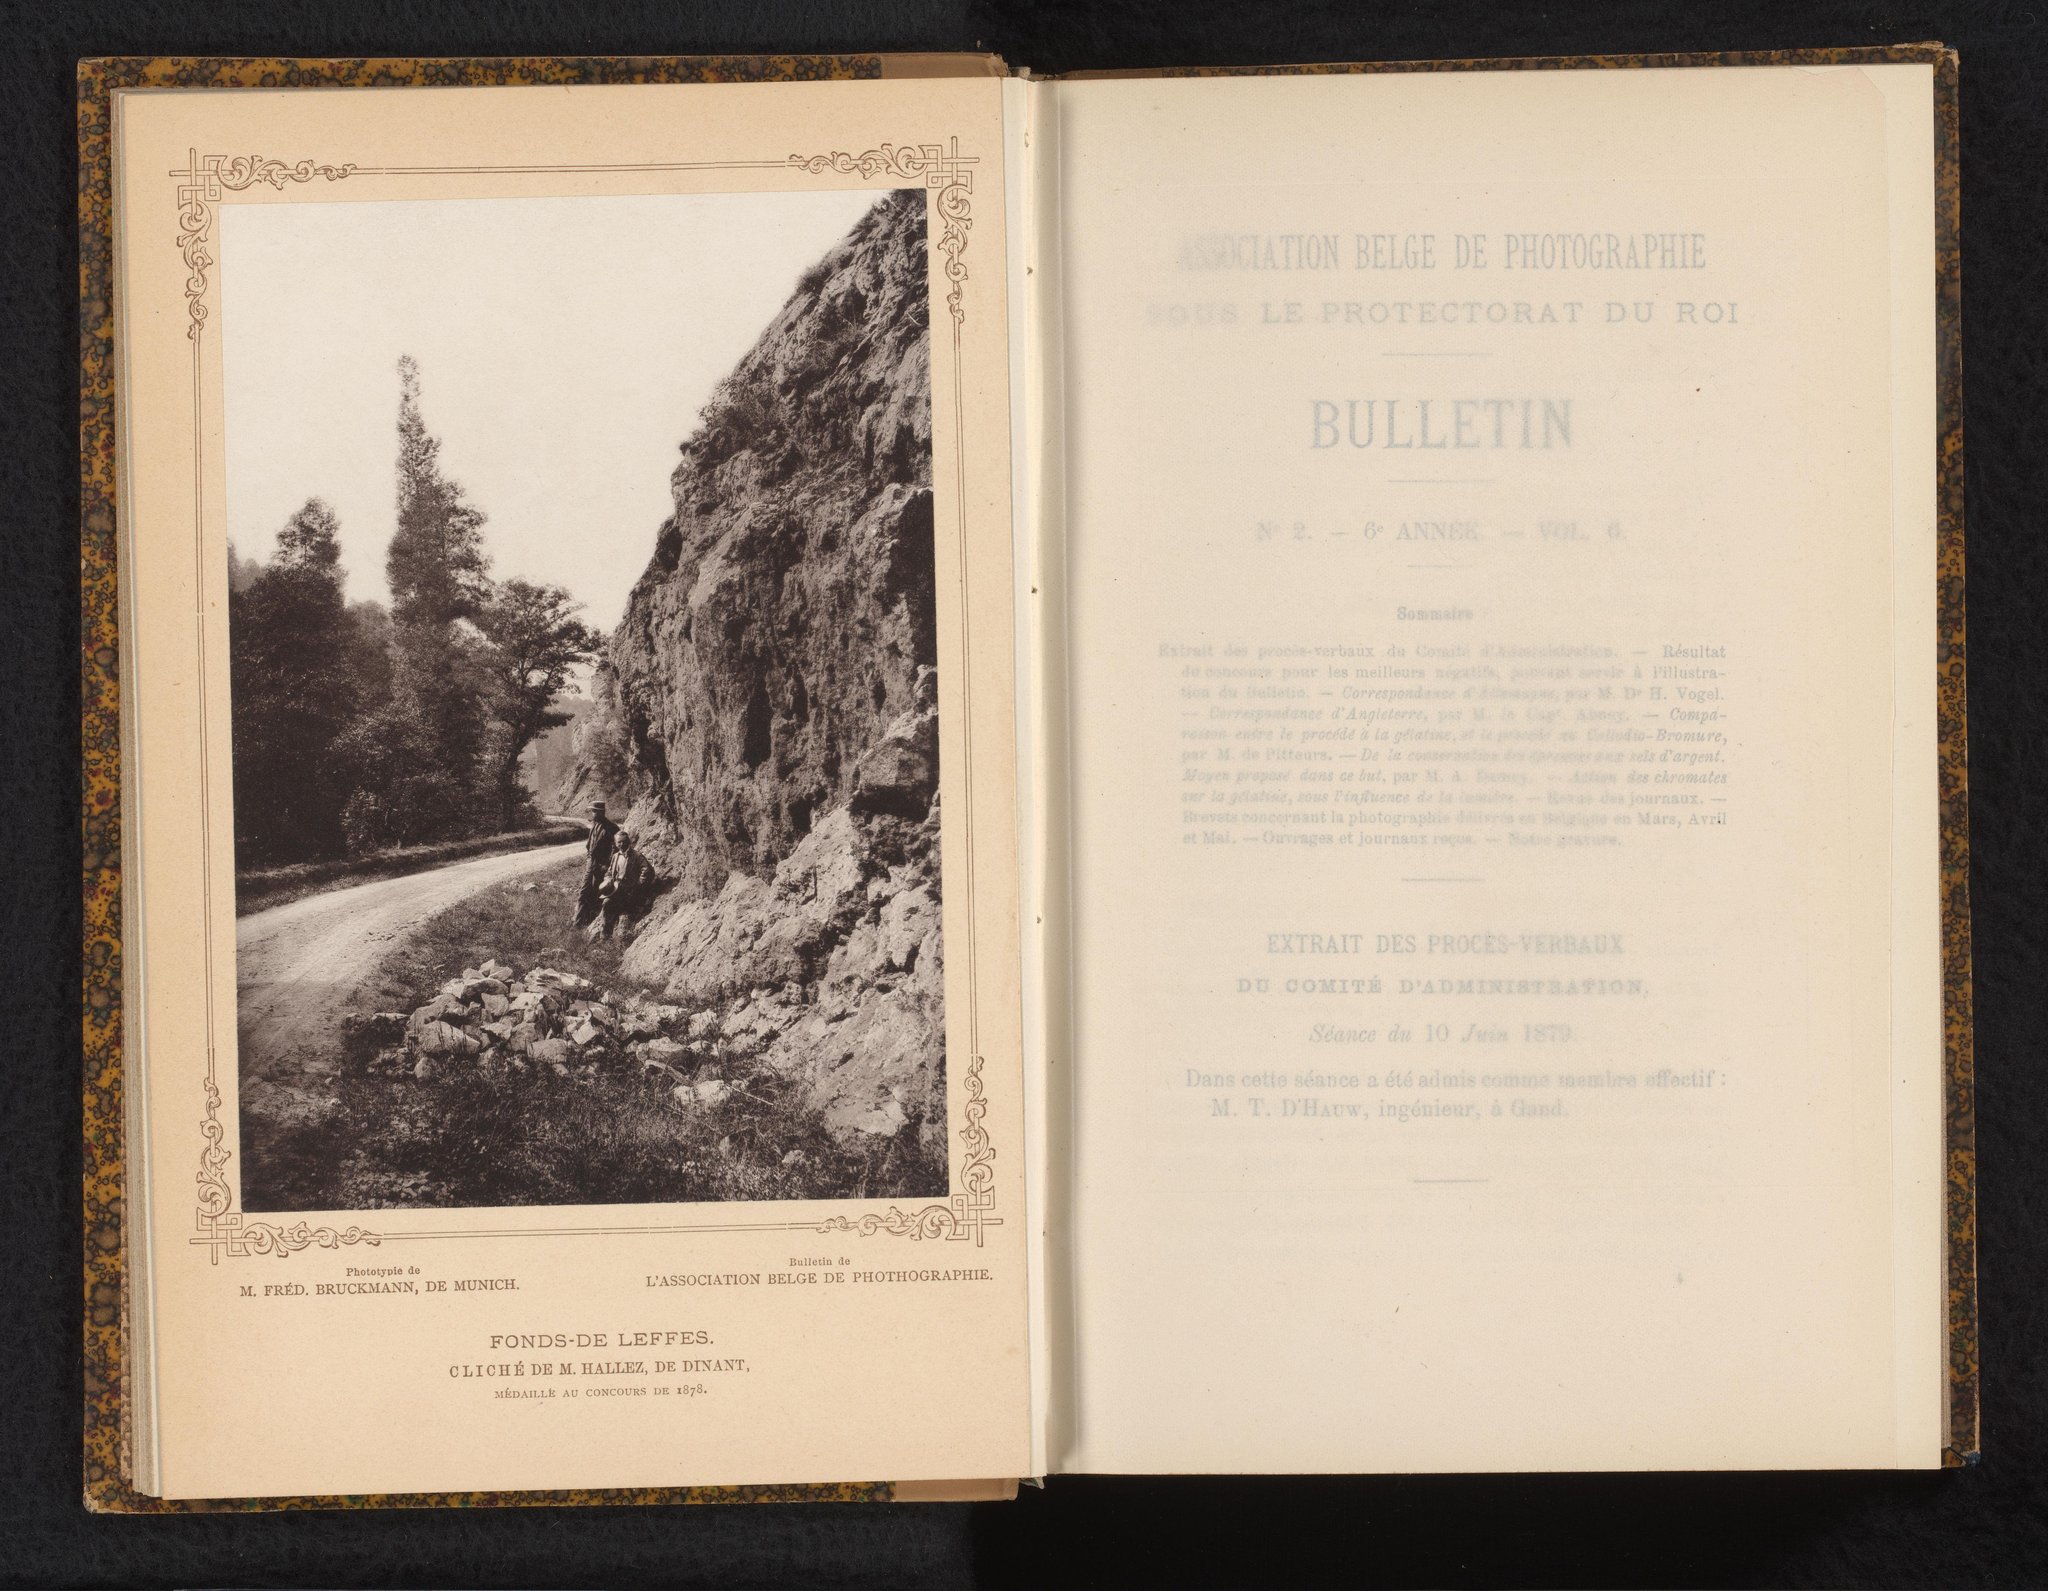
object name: page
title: Fonds-de-Leffes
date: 1874-1879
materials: paper, cardboard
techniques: photograph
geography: munich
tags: road, path, rock-formations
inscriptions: inscription: ‘Médaillé au concours de 1878’